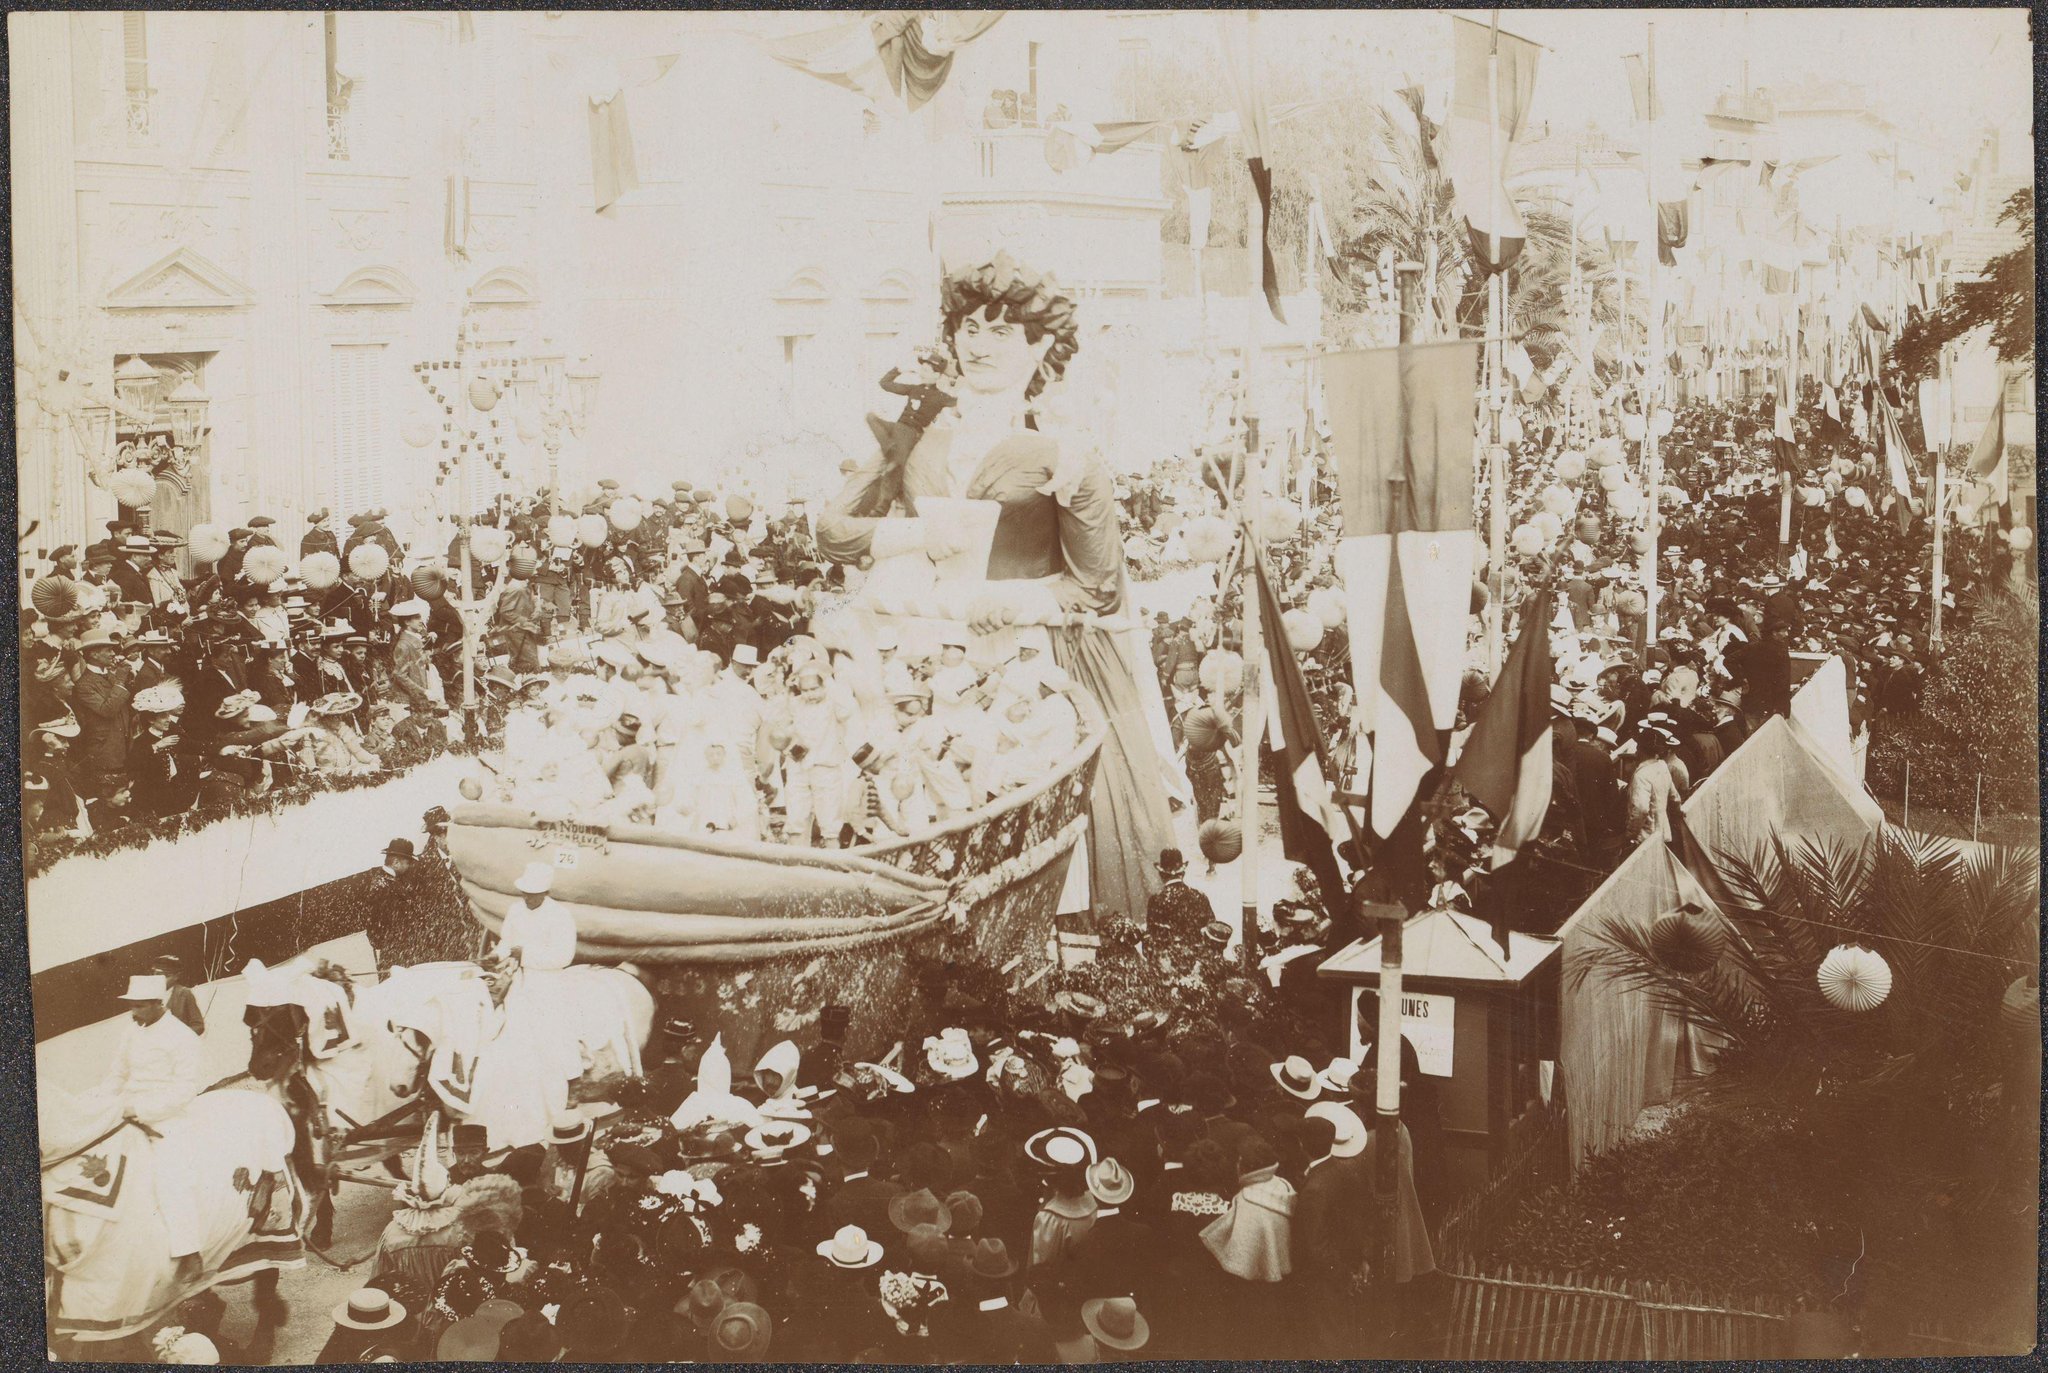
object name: album leaf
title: Optocht met publiek en praalwagens, mogelijk in Menton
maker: Anonymous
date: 1880-1910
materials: paper, photographic support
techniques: daylight paper print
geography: france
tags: festivities (+ parade, pageant, cavalcade ~ festive activities), france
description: Onderdeel van Reisalbum met bezienswaardigheden in Engeland, Zwitserland, Frankrijk en Duitsland.